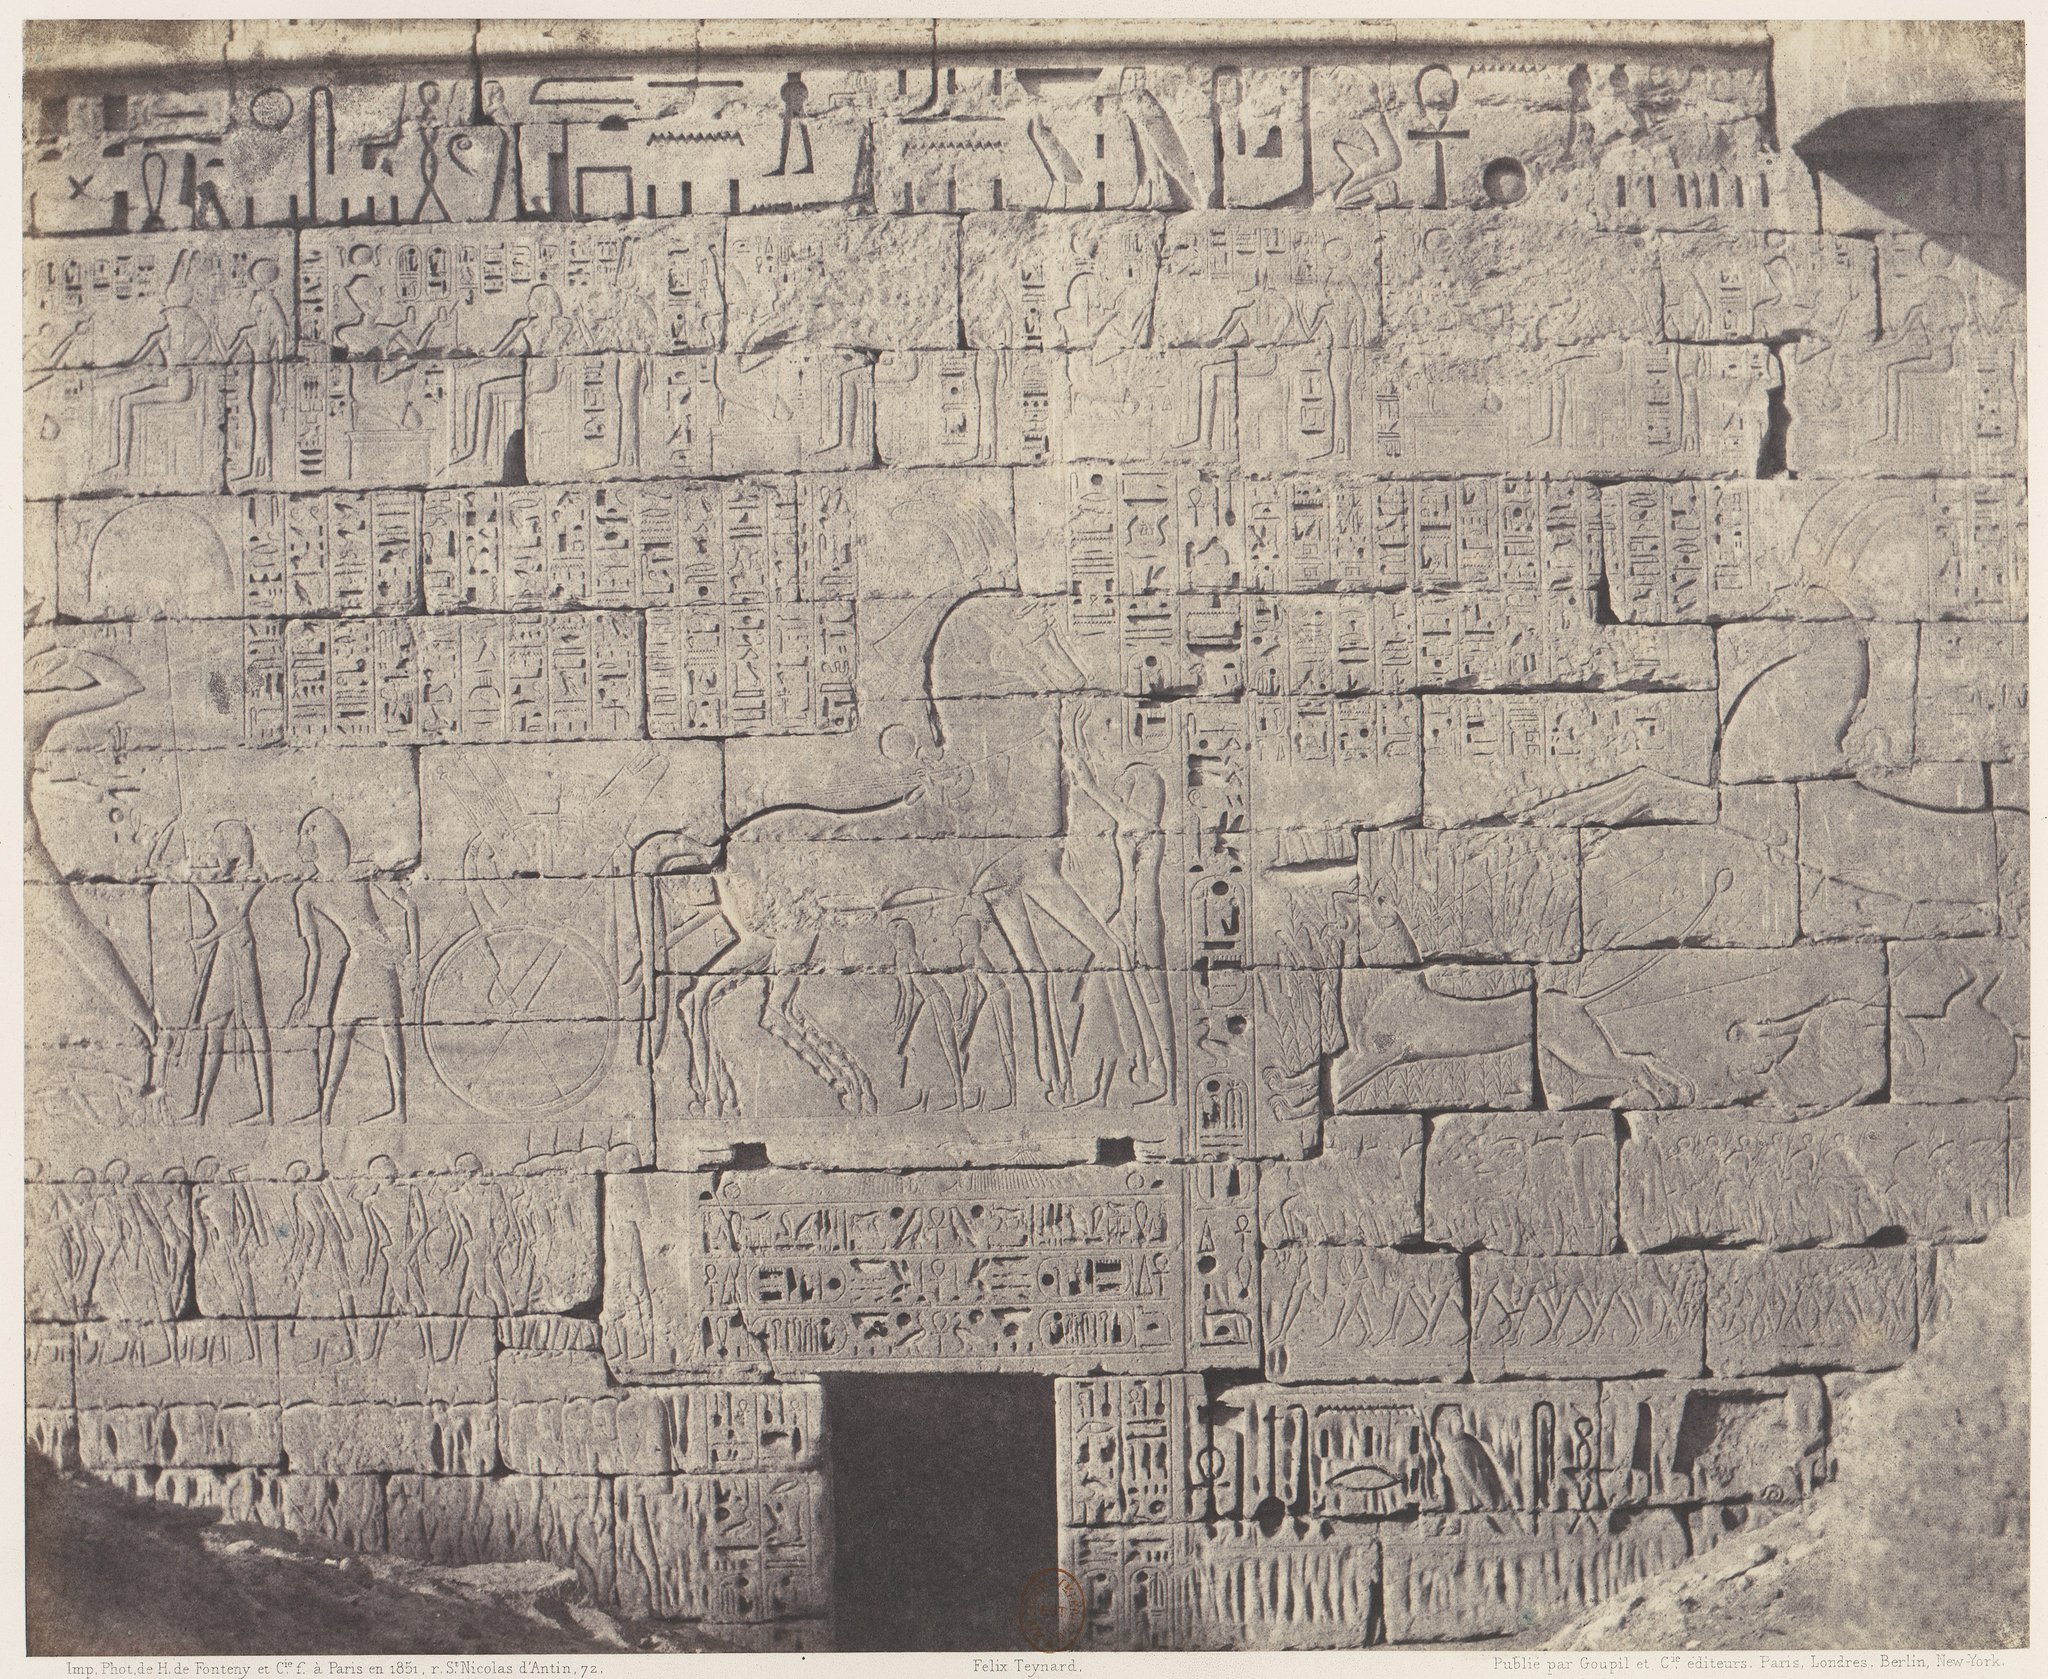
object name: photograph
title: Médînet-Abou (Thèbes), Constructions Postérieures - Fragment de Sculptures Sur la Face Nord-Est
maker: félix teynard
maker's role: artist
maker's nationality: french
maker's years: 1817-1892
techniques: paper negative, salted paper print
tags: architecture,hieroglyphs